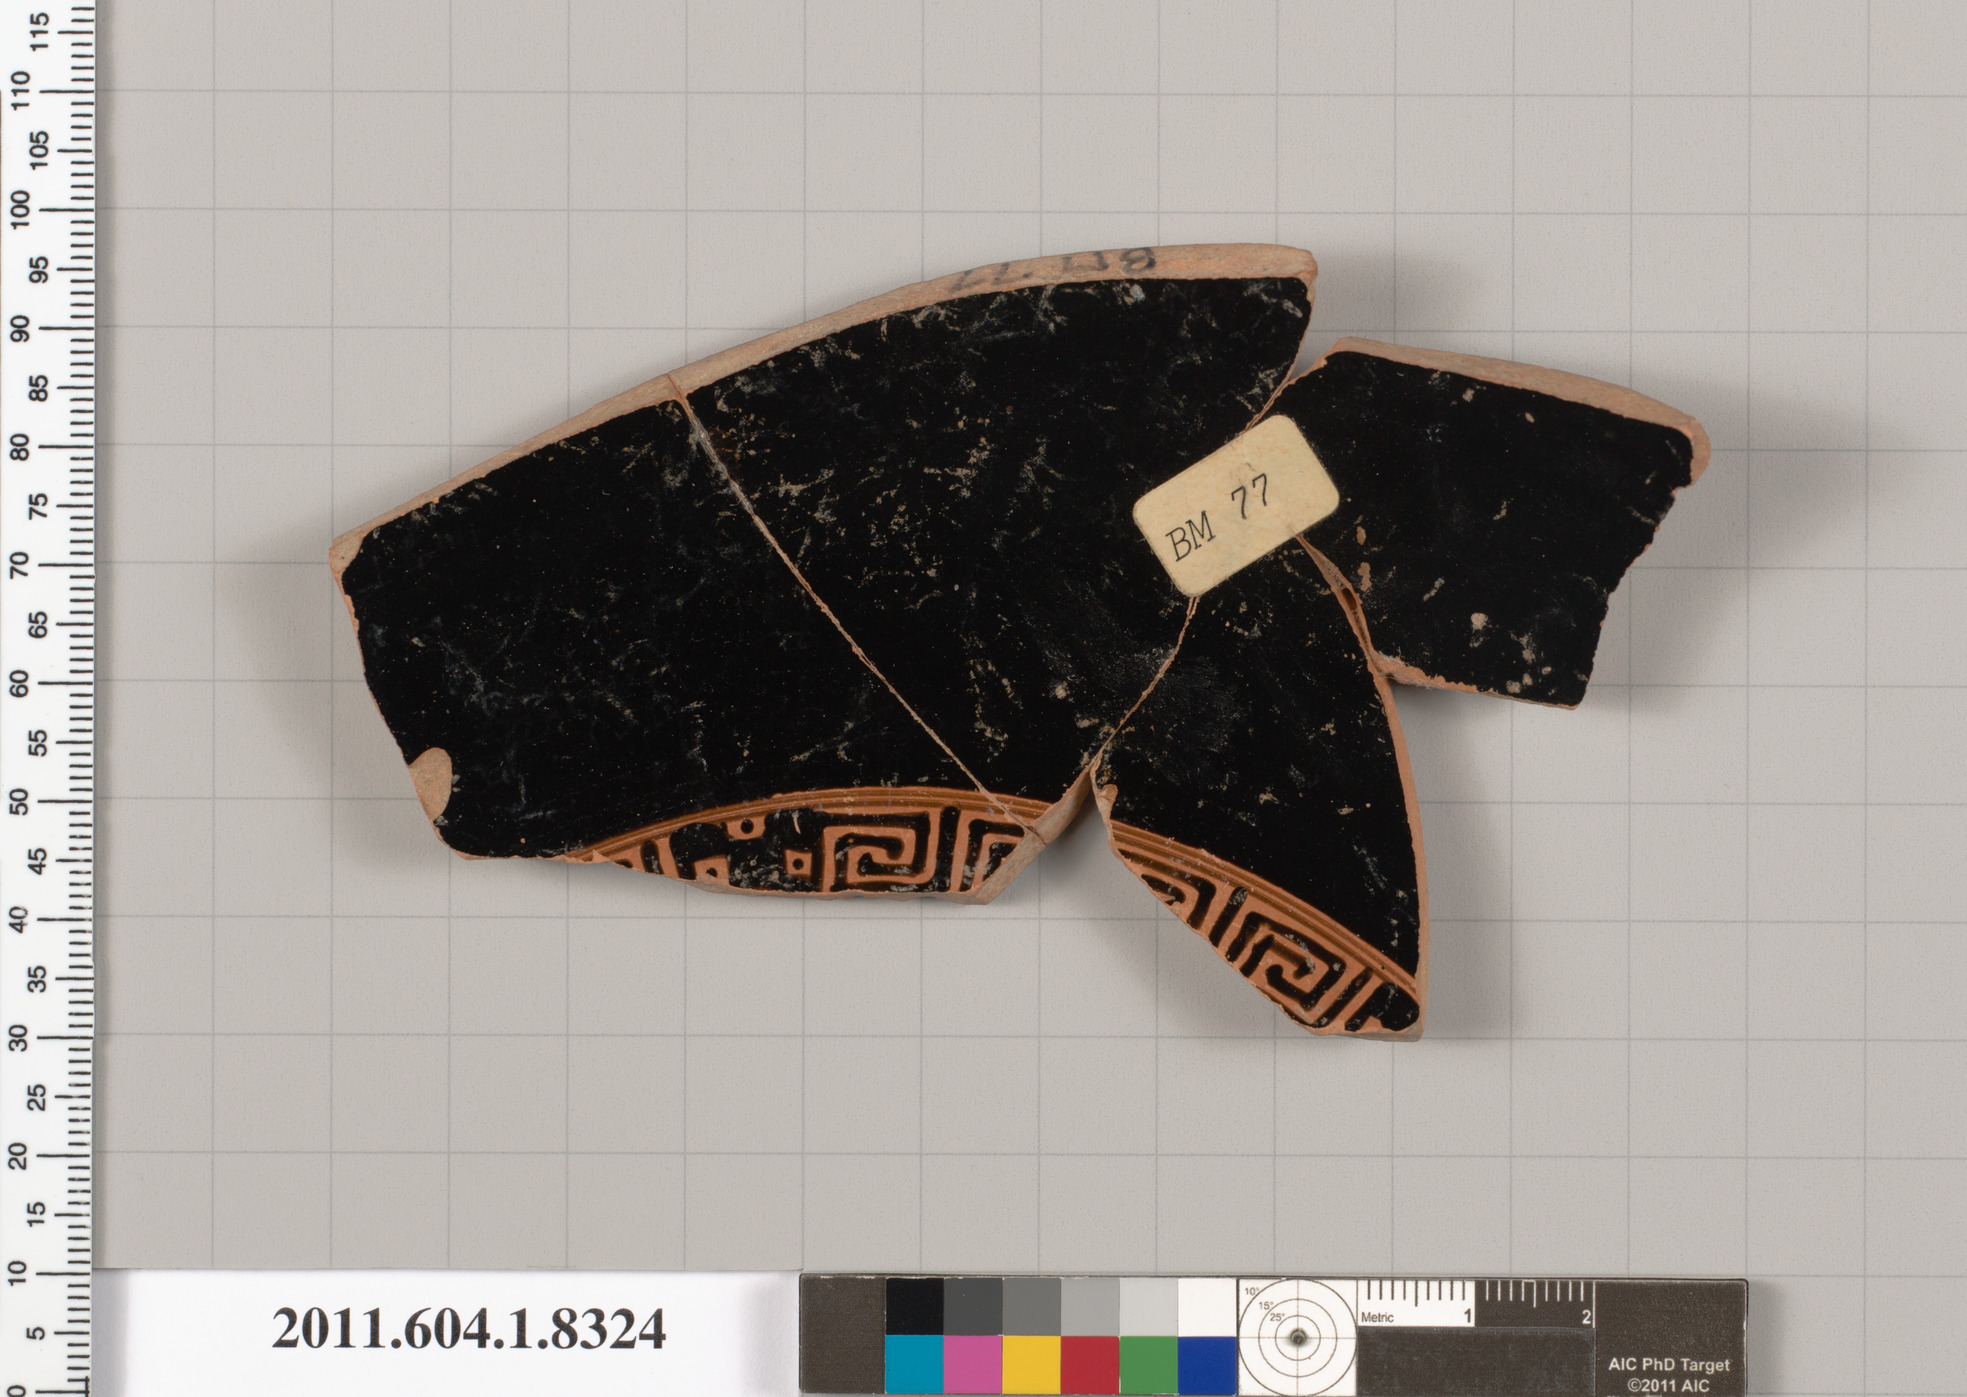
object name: kylix fragment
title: Terracotta fragment of a kylix (drinking cup)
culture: greek, attic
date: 467-435 BCE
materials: terracotta